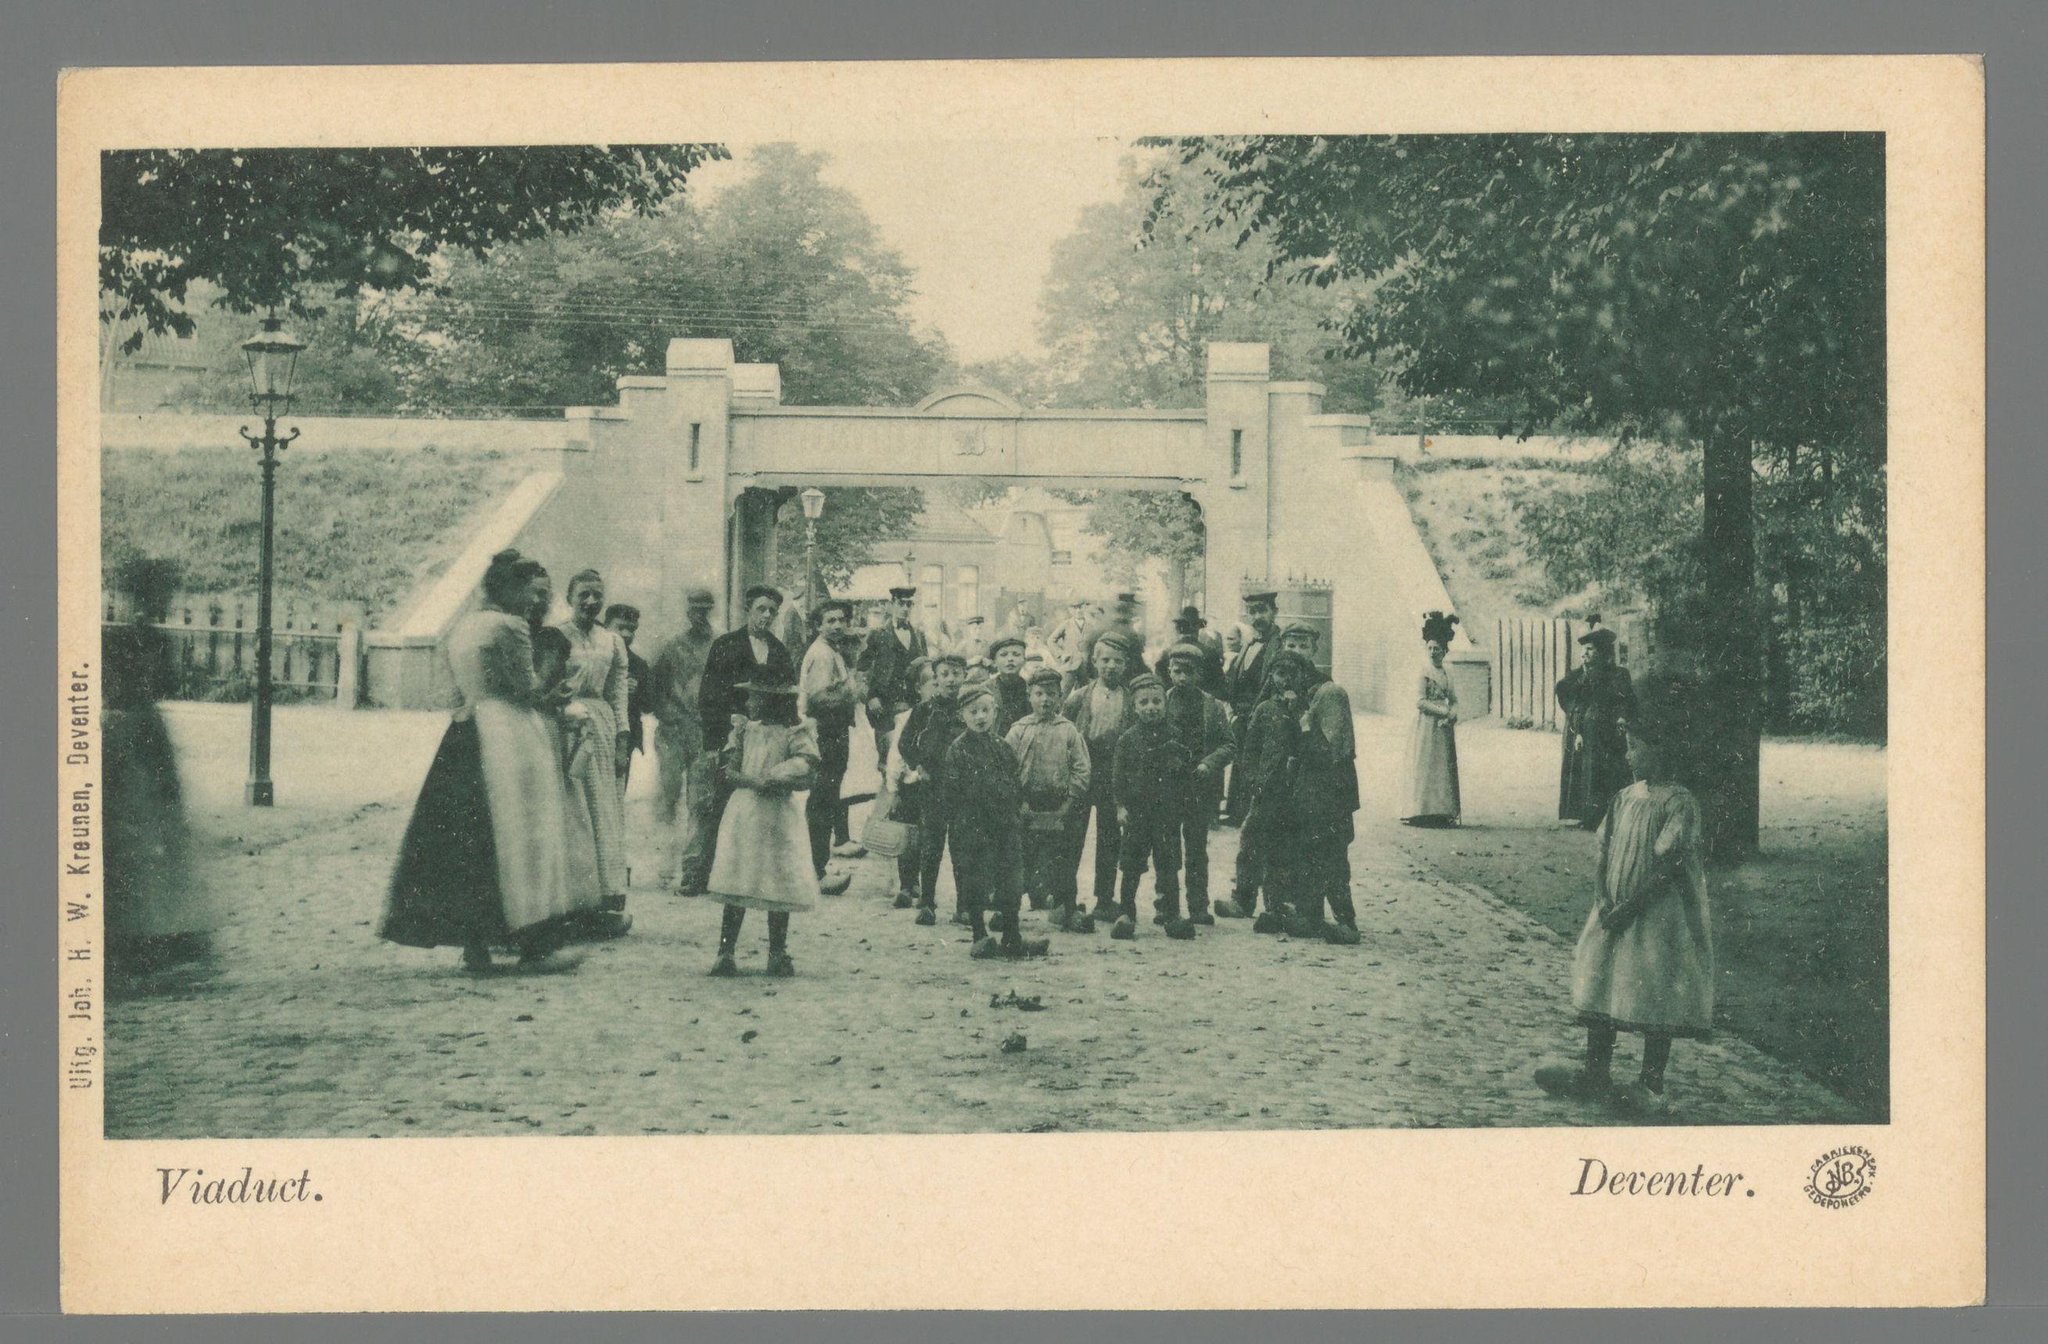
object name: photomechanical print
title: Viaduct. Deventer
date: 1892-1905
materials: cardboard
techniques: photograph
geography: deventer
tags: viaduct, deventer